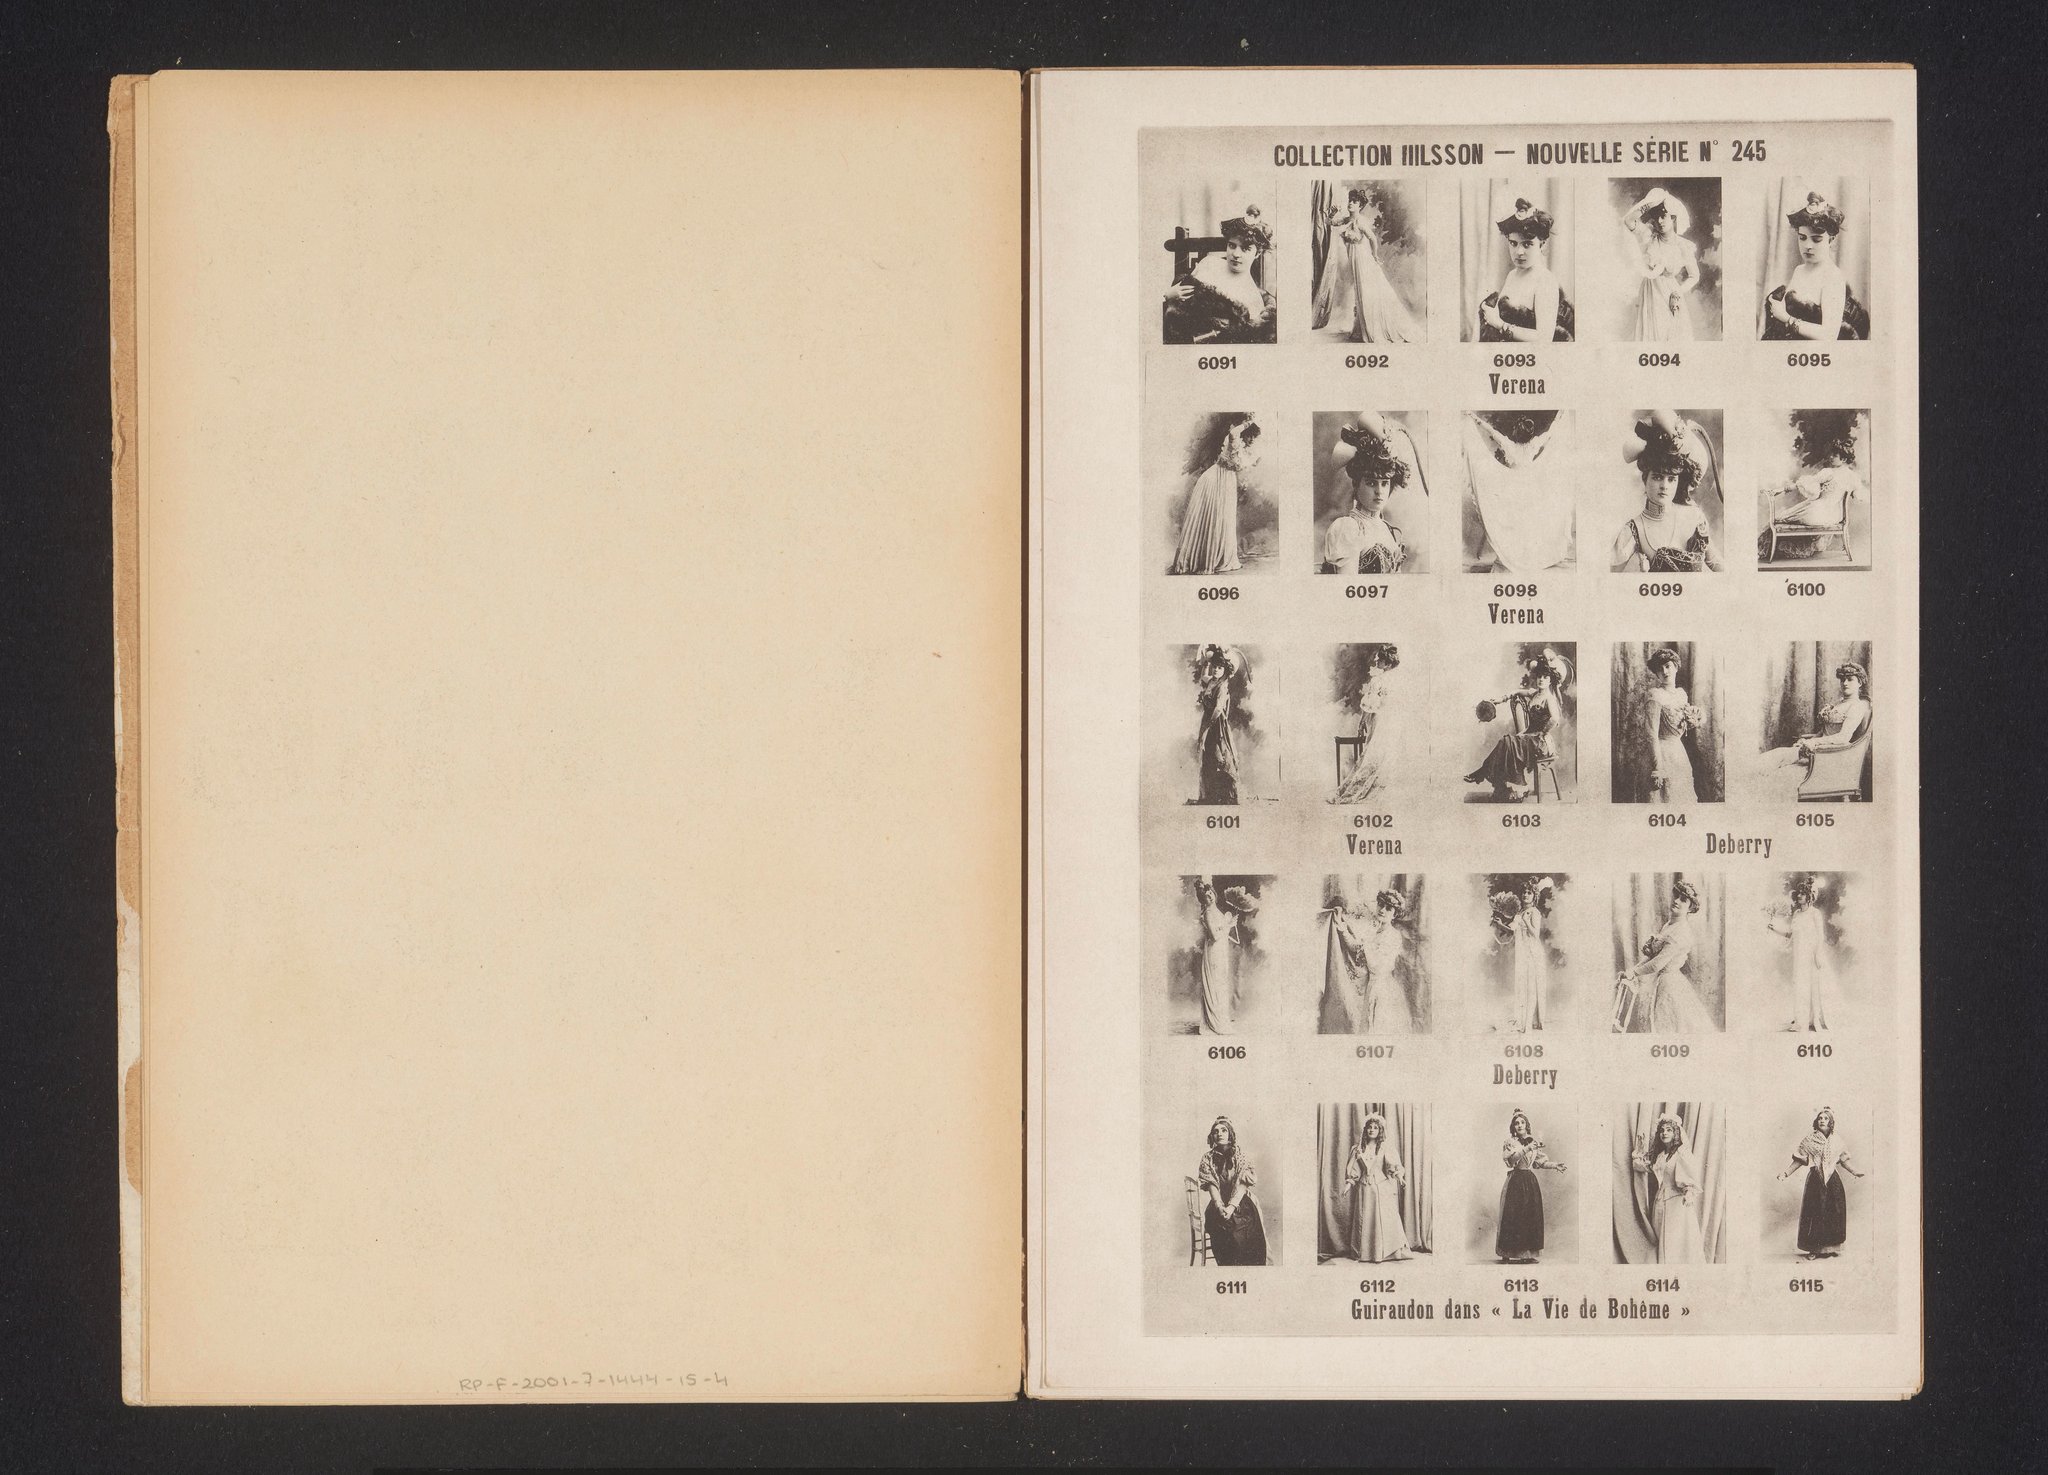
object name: photomechanical print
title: 25 portretten van Verena, Deberry en Guiraudon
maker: Anonymous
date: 1894-1899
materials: paper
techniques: photograph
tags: historical persons - bb - woman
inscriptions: number: ‘No 245’, inscription: ‘Verena/ Verena/ Verena Deberry/ Deberry/ Guiraudon dans < < La Vie de Bohème > >’